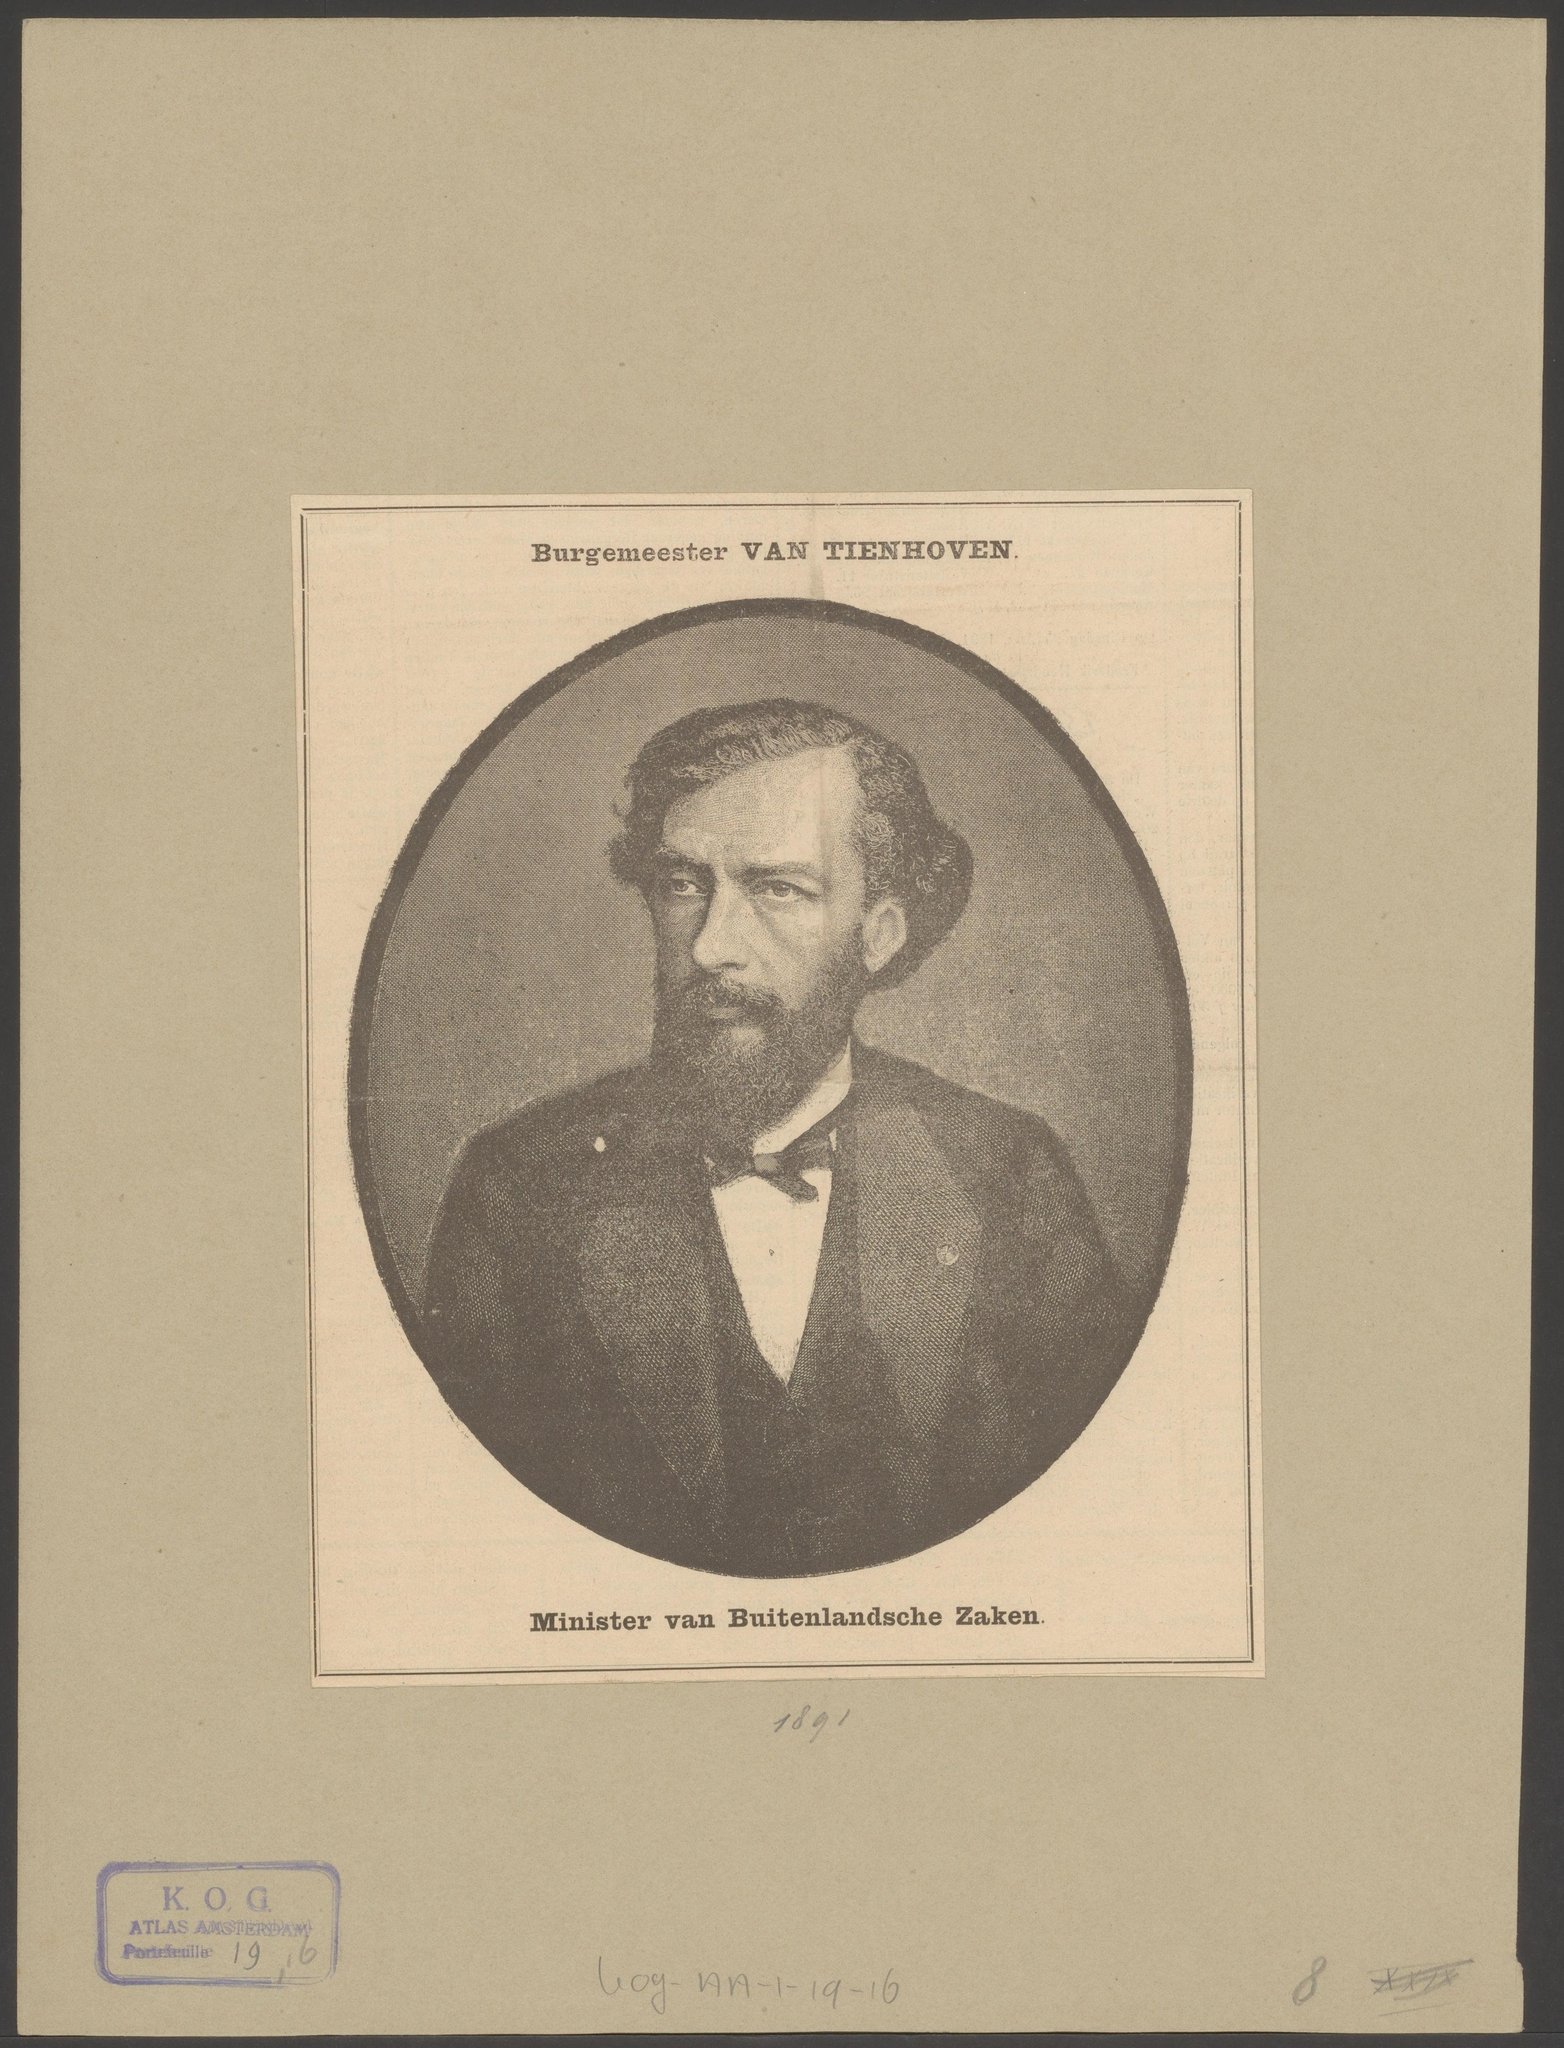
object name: photomechanical print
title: Portret van Gijsbert van Tienhoven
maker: Anonymous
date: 1891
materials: paper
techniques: letterpress printing, line block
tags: mayor, gijsbert van tienhoven, mayor, burgomaster, politician, e.g. party leader, amsterdam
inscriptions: date: ‘1891’, collector's mark: ‘19,16’ Lugt 1641b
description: Onderwerpsrubriek binnen de Atlas Amsterdam: Herinneringen aan regeringsleden en hunne huisgezinnen [na 1800].